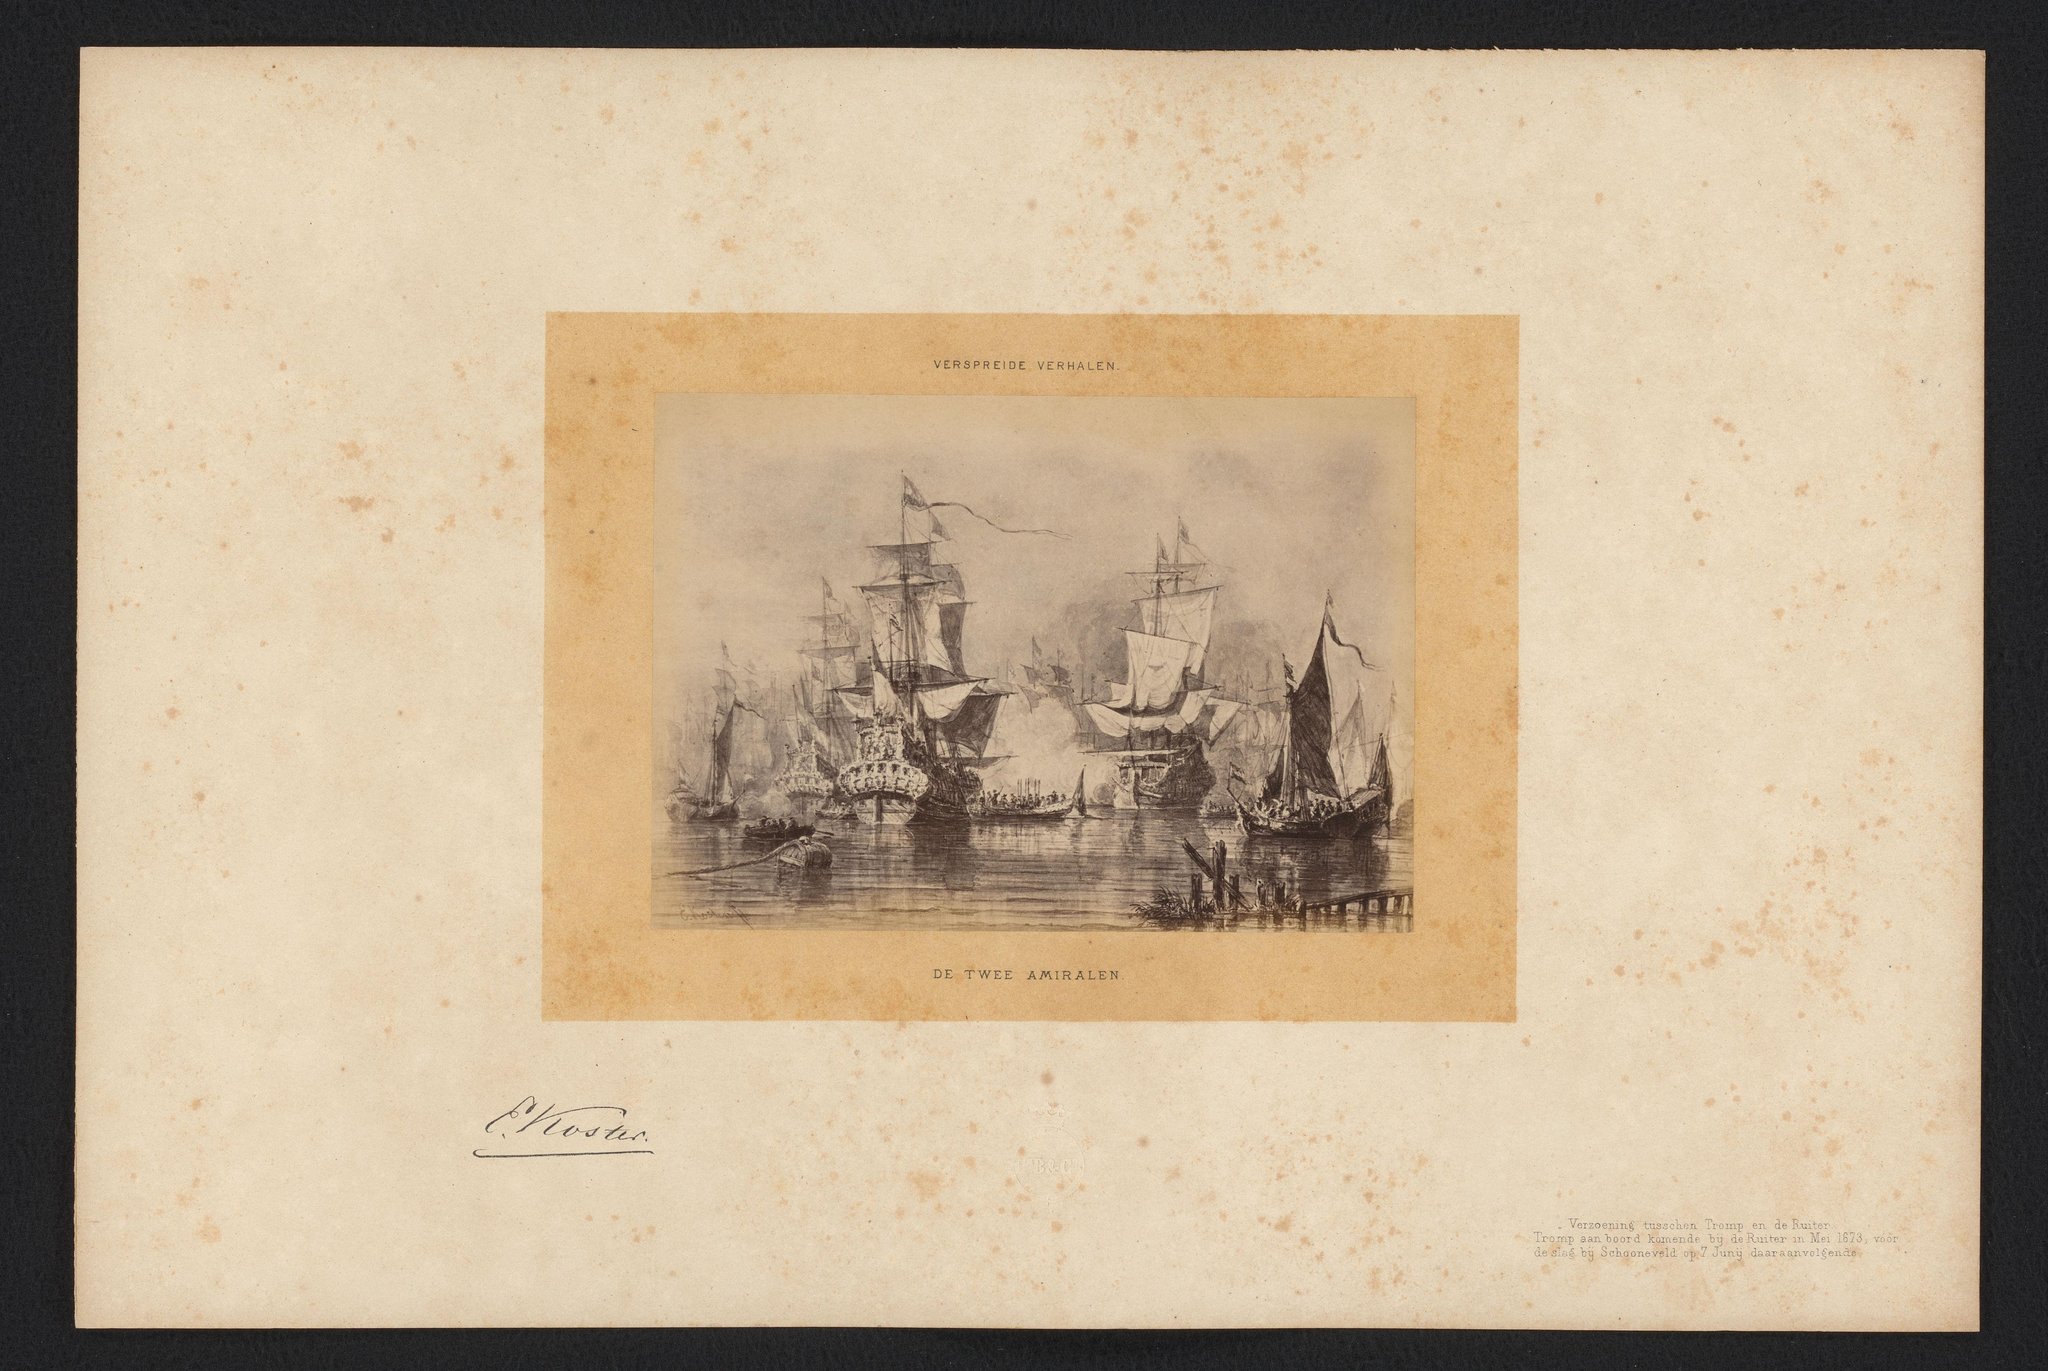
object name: reproduction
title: Fotoreproductie van een tekening van een vloot schepen door Everhardus Koster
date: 1865-1870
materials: cardboard, paper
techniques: albumen print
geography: haarlem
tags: sailing-ship, sailing-boat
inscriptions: signature: ‘E. Koster’, inscription: ‘"Verzoening tusschen Tromp (...) 7 Junij daaraanvolgende.’